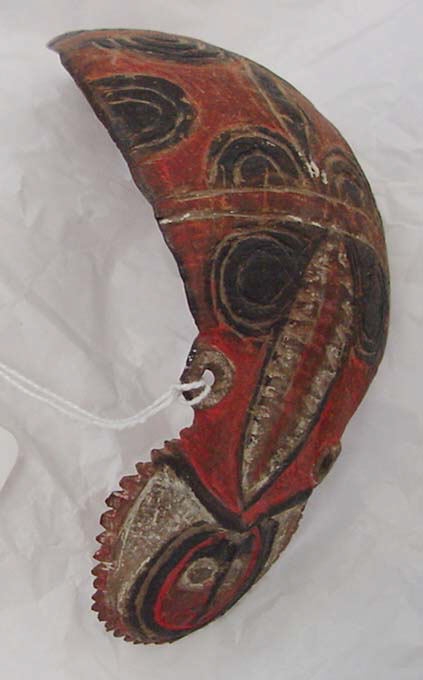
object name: phallocrypt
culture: oceanic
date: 1801-1900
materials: pigment